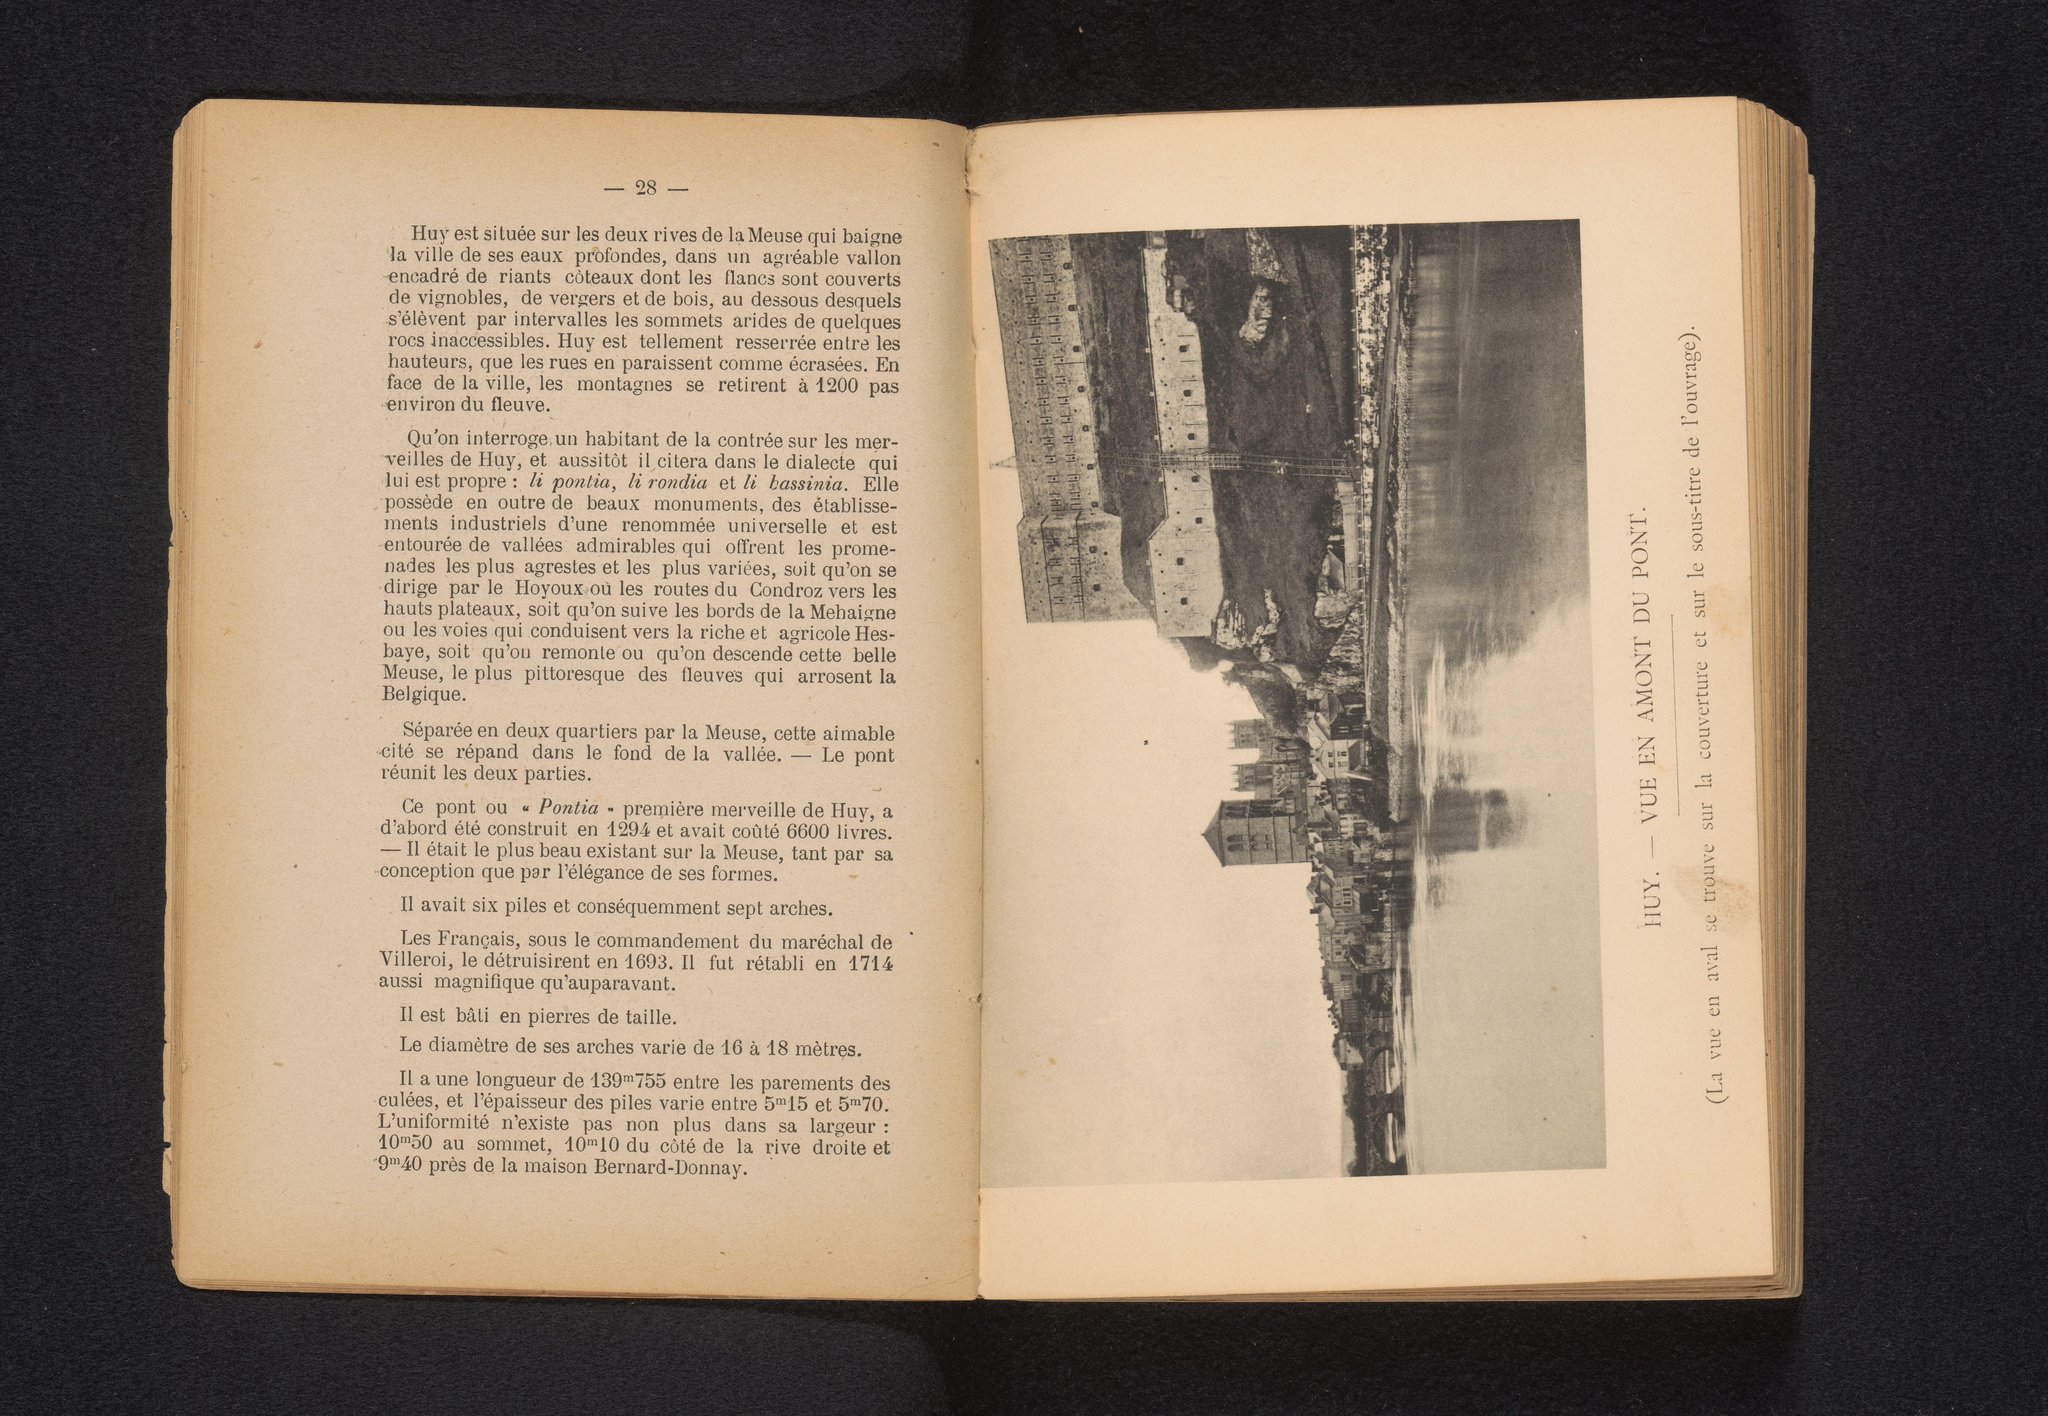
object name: page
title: Huy. Vue en amont de pont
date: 1885-1890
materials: paper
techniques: photograph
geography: brussels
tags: fortress, city-view in general; 'veduta', river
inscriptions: inscription: ‘La vue en aval se trouve sur la couverture et sur le sous-titre de l'ouvrage’